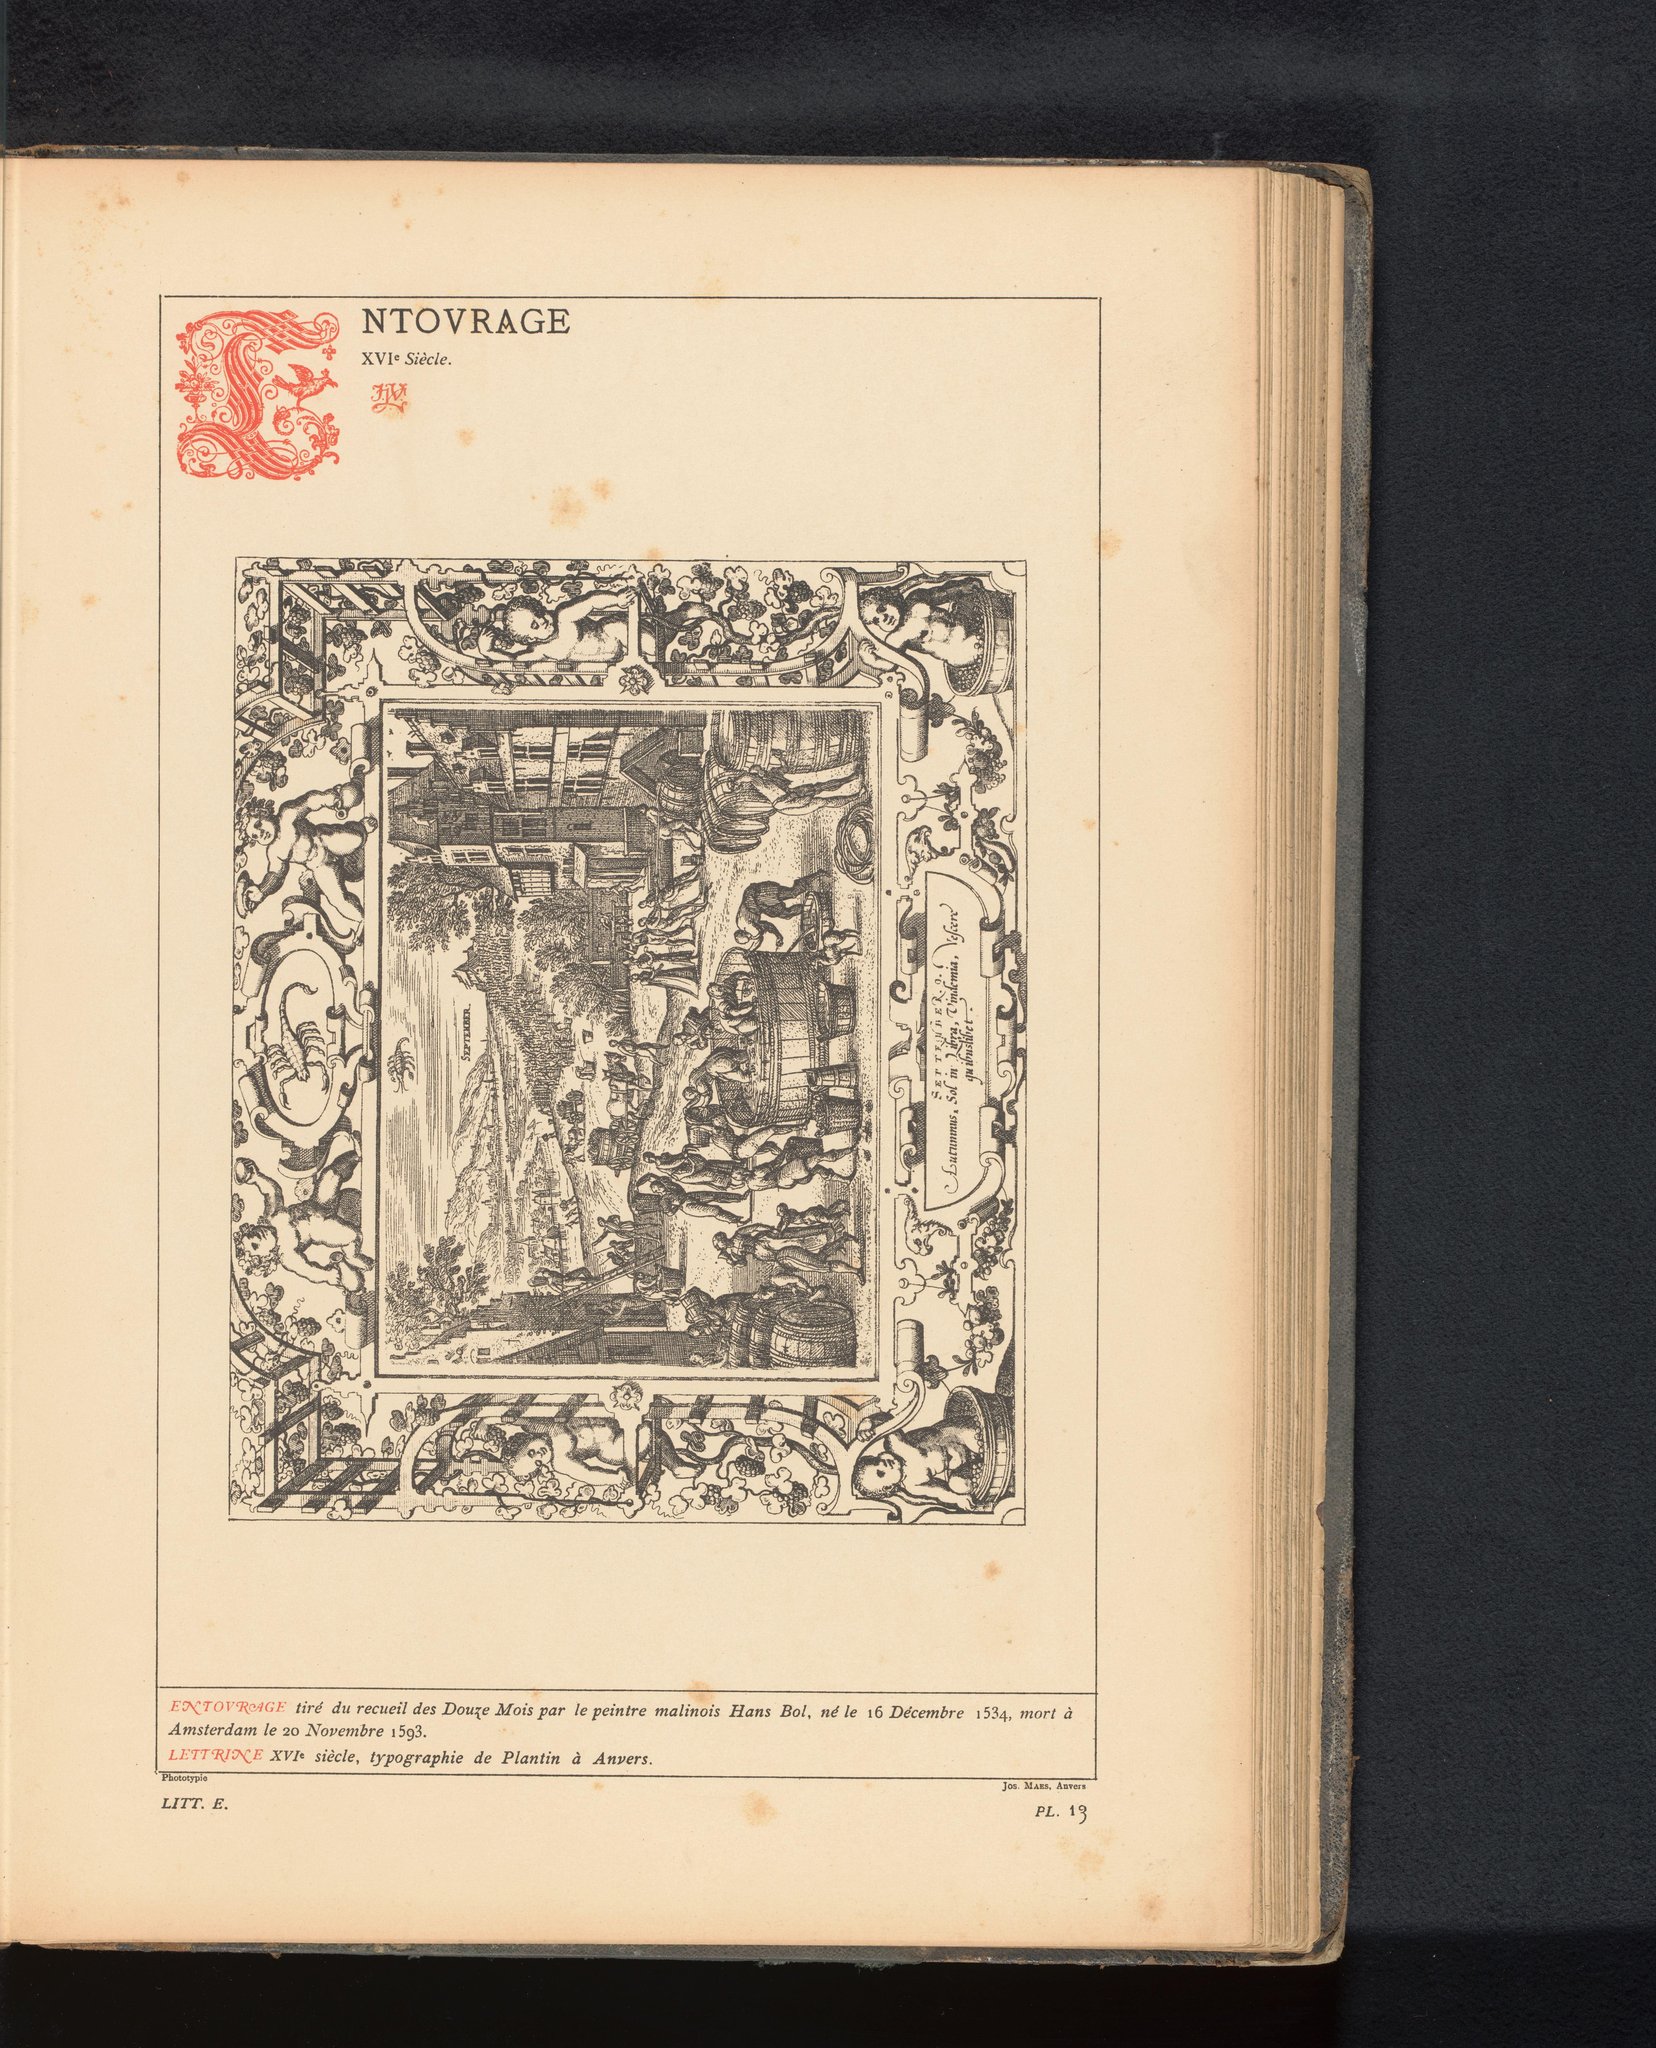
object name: page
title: Entourage, XVIe Siècle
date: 1875-1880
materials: paper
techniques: photolithography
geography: antwerp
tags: september; 'settembre' (ripa), ornament ~ grotesque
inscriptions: inscription: ‘LITT. E. - PL. 13’, monogram: ‘JJvY’, inscription: ‘ENTOURAGE tiré du (...)’